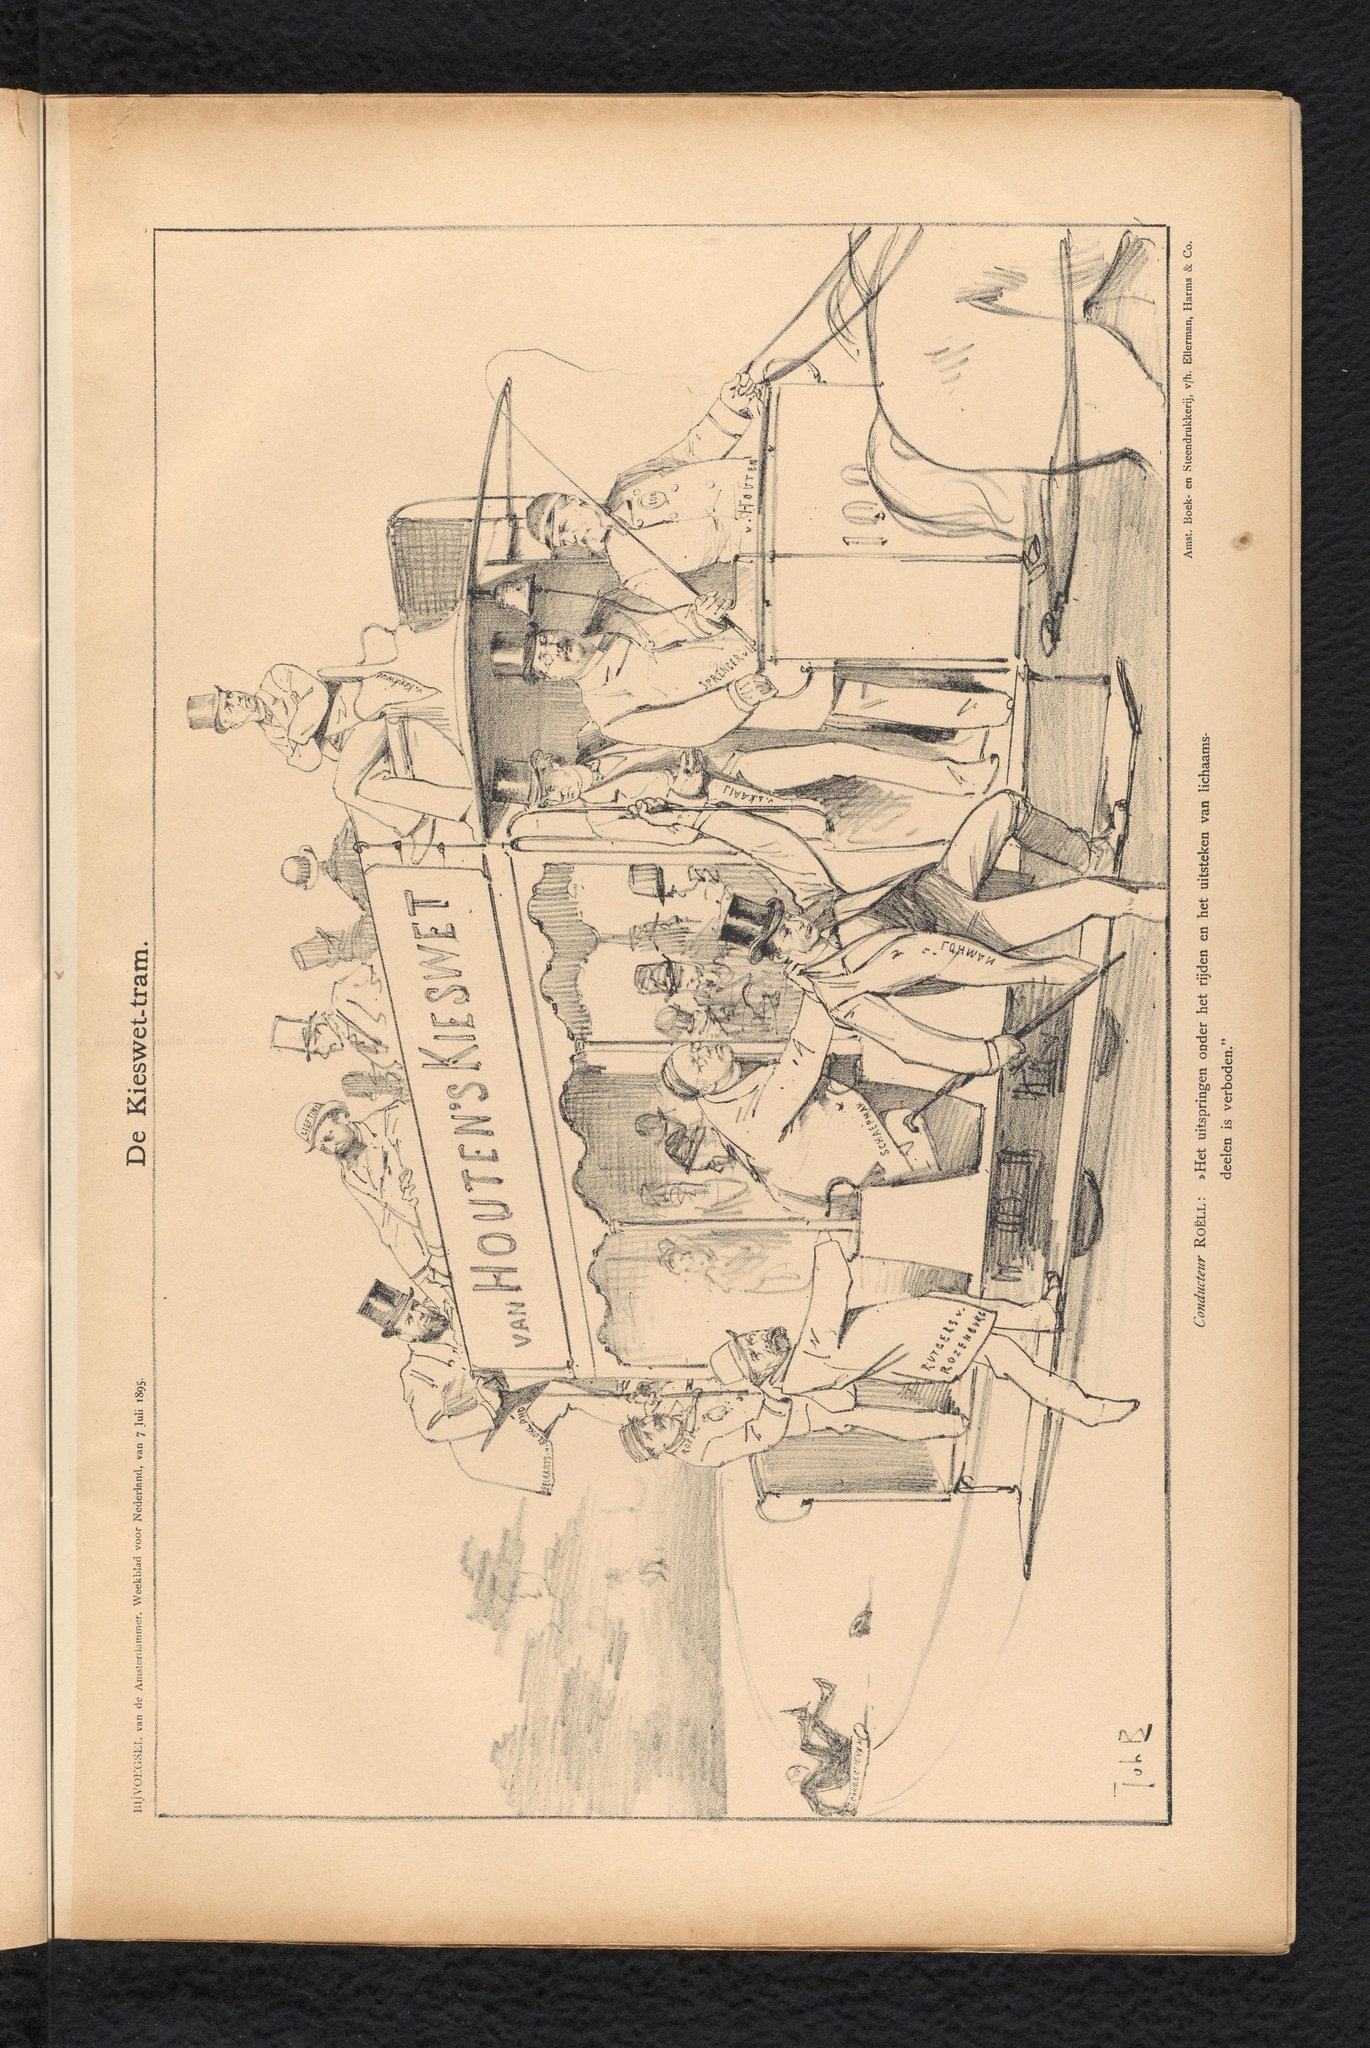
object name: cartoon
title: De Kieswet-tram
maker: johan braakensiek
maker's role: draughtsman, print maker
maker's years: 1858-1940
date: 1895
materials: paper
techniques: lithograph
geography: amsterdam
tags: the hague, politician, amsterdam, haarlem, jonkheer alexander frederik de savornin lohman, rome, priest, herman johannes aloysius maria schaepman, rotterdam, samuel van houten, diligence, omnibus, horse-tram, the right to vote, the compulsory vote, political caricatures and satires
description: Premier Roëll als conducteur op de paardentram aangeduid als 'Van Houtens's Kieswet'. Minister Samuel van Houten is de koetsier, naast hem minister Sprenger van Eyk. Andere passagiers zijn: Van der Kaay, dr. Schaepman, De Savornin Lohman, Rutgers van Rozenburg, Beelaerts van Blokland, Lieftinck en Van Kerkwijk.